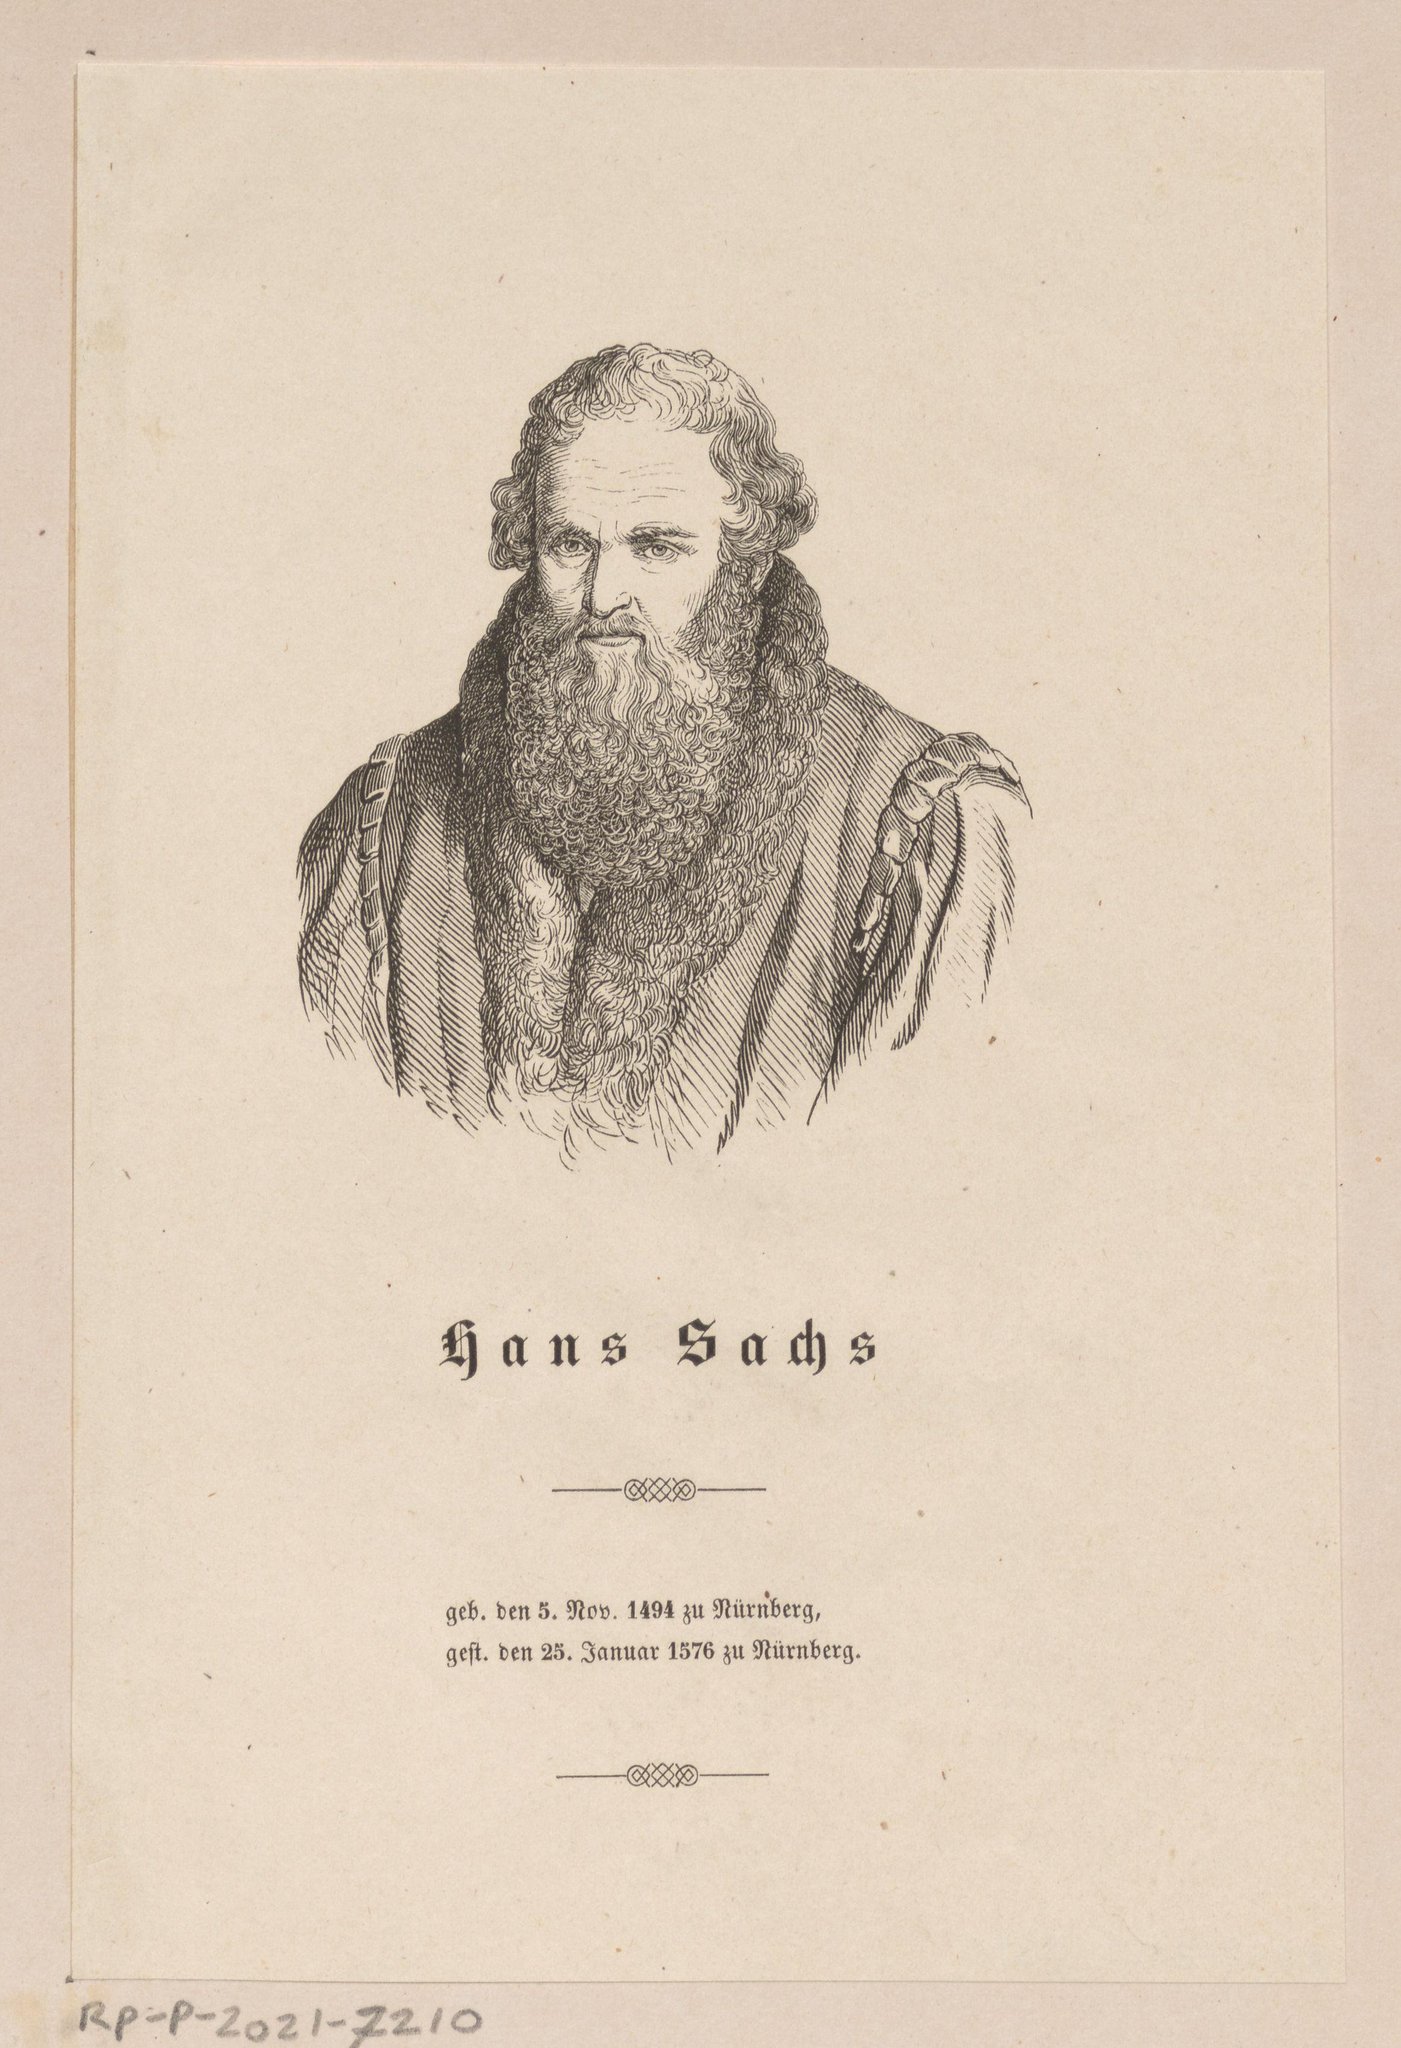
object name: print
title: Portret van Hans Sachs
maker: Anonymous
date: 1800-1899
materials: paper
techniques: engraving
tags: hans sachs, historical persons, writer, poet, author